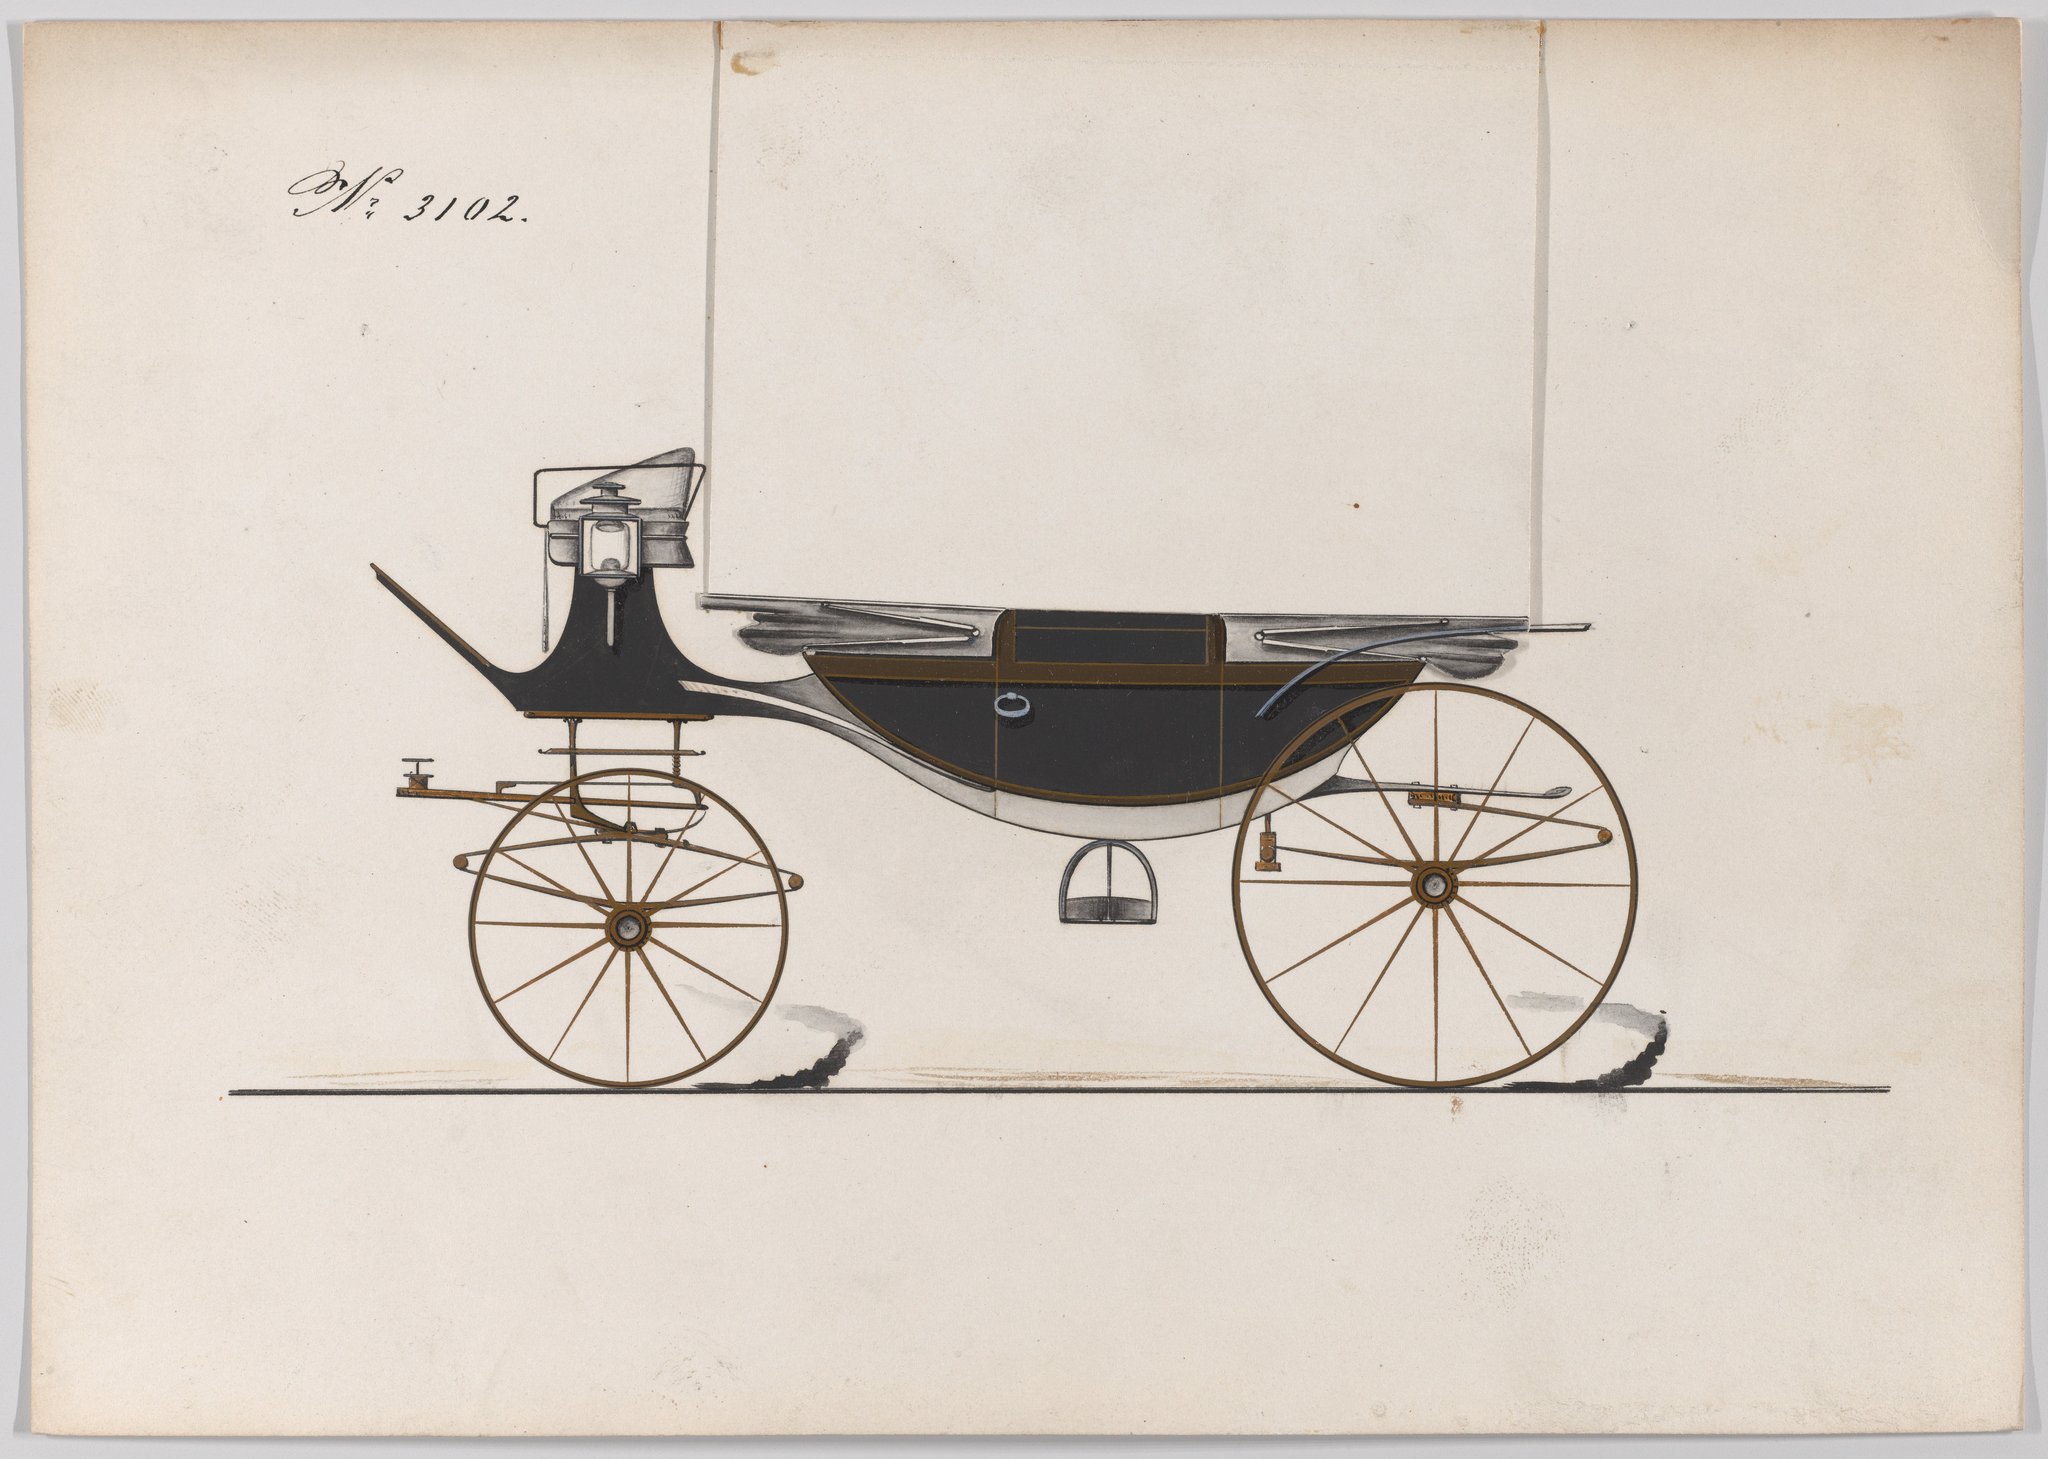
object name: drawing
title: Design for Landau, No. 3102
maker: brewster & co.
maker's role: manufacturer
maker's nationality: american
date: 1875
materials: gouache, gum arabic, ink, watercolor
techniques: pen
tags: carriages